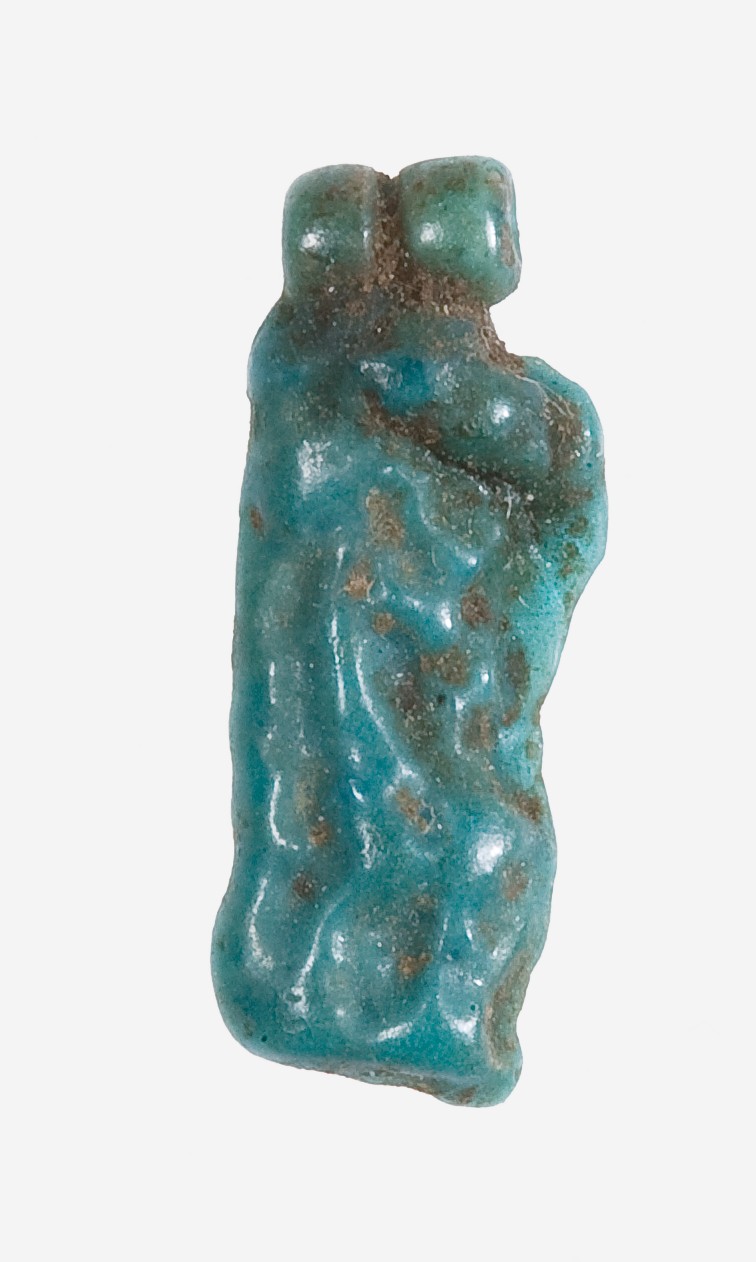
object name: amulet, taweret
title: Amulet: Taweret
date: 1390-1352 BCE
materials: faience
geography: egypt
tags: taweret